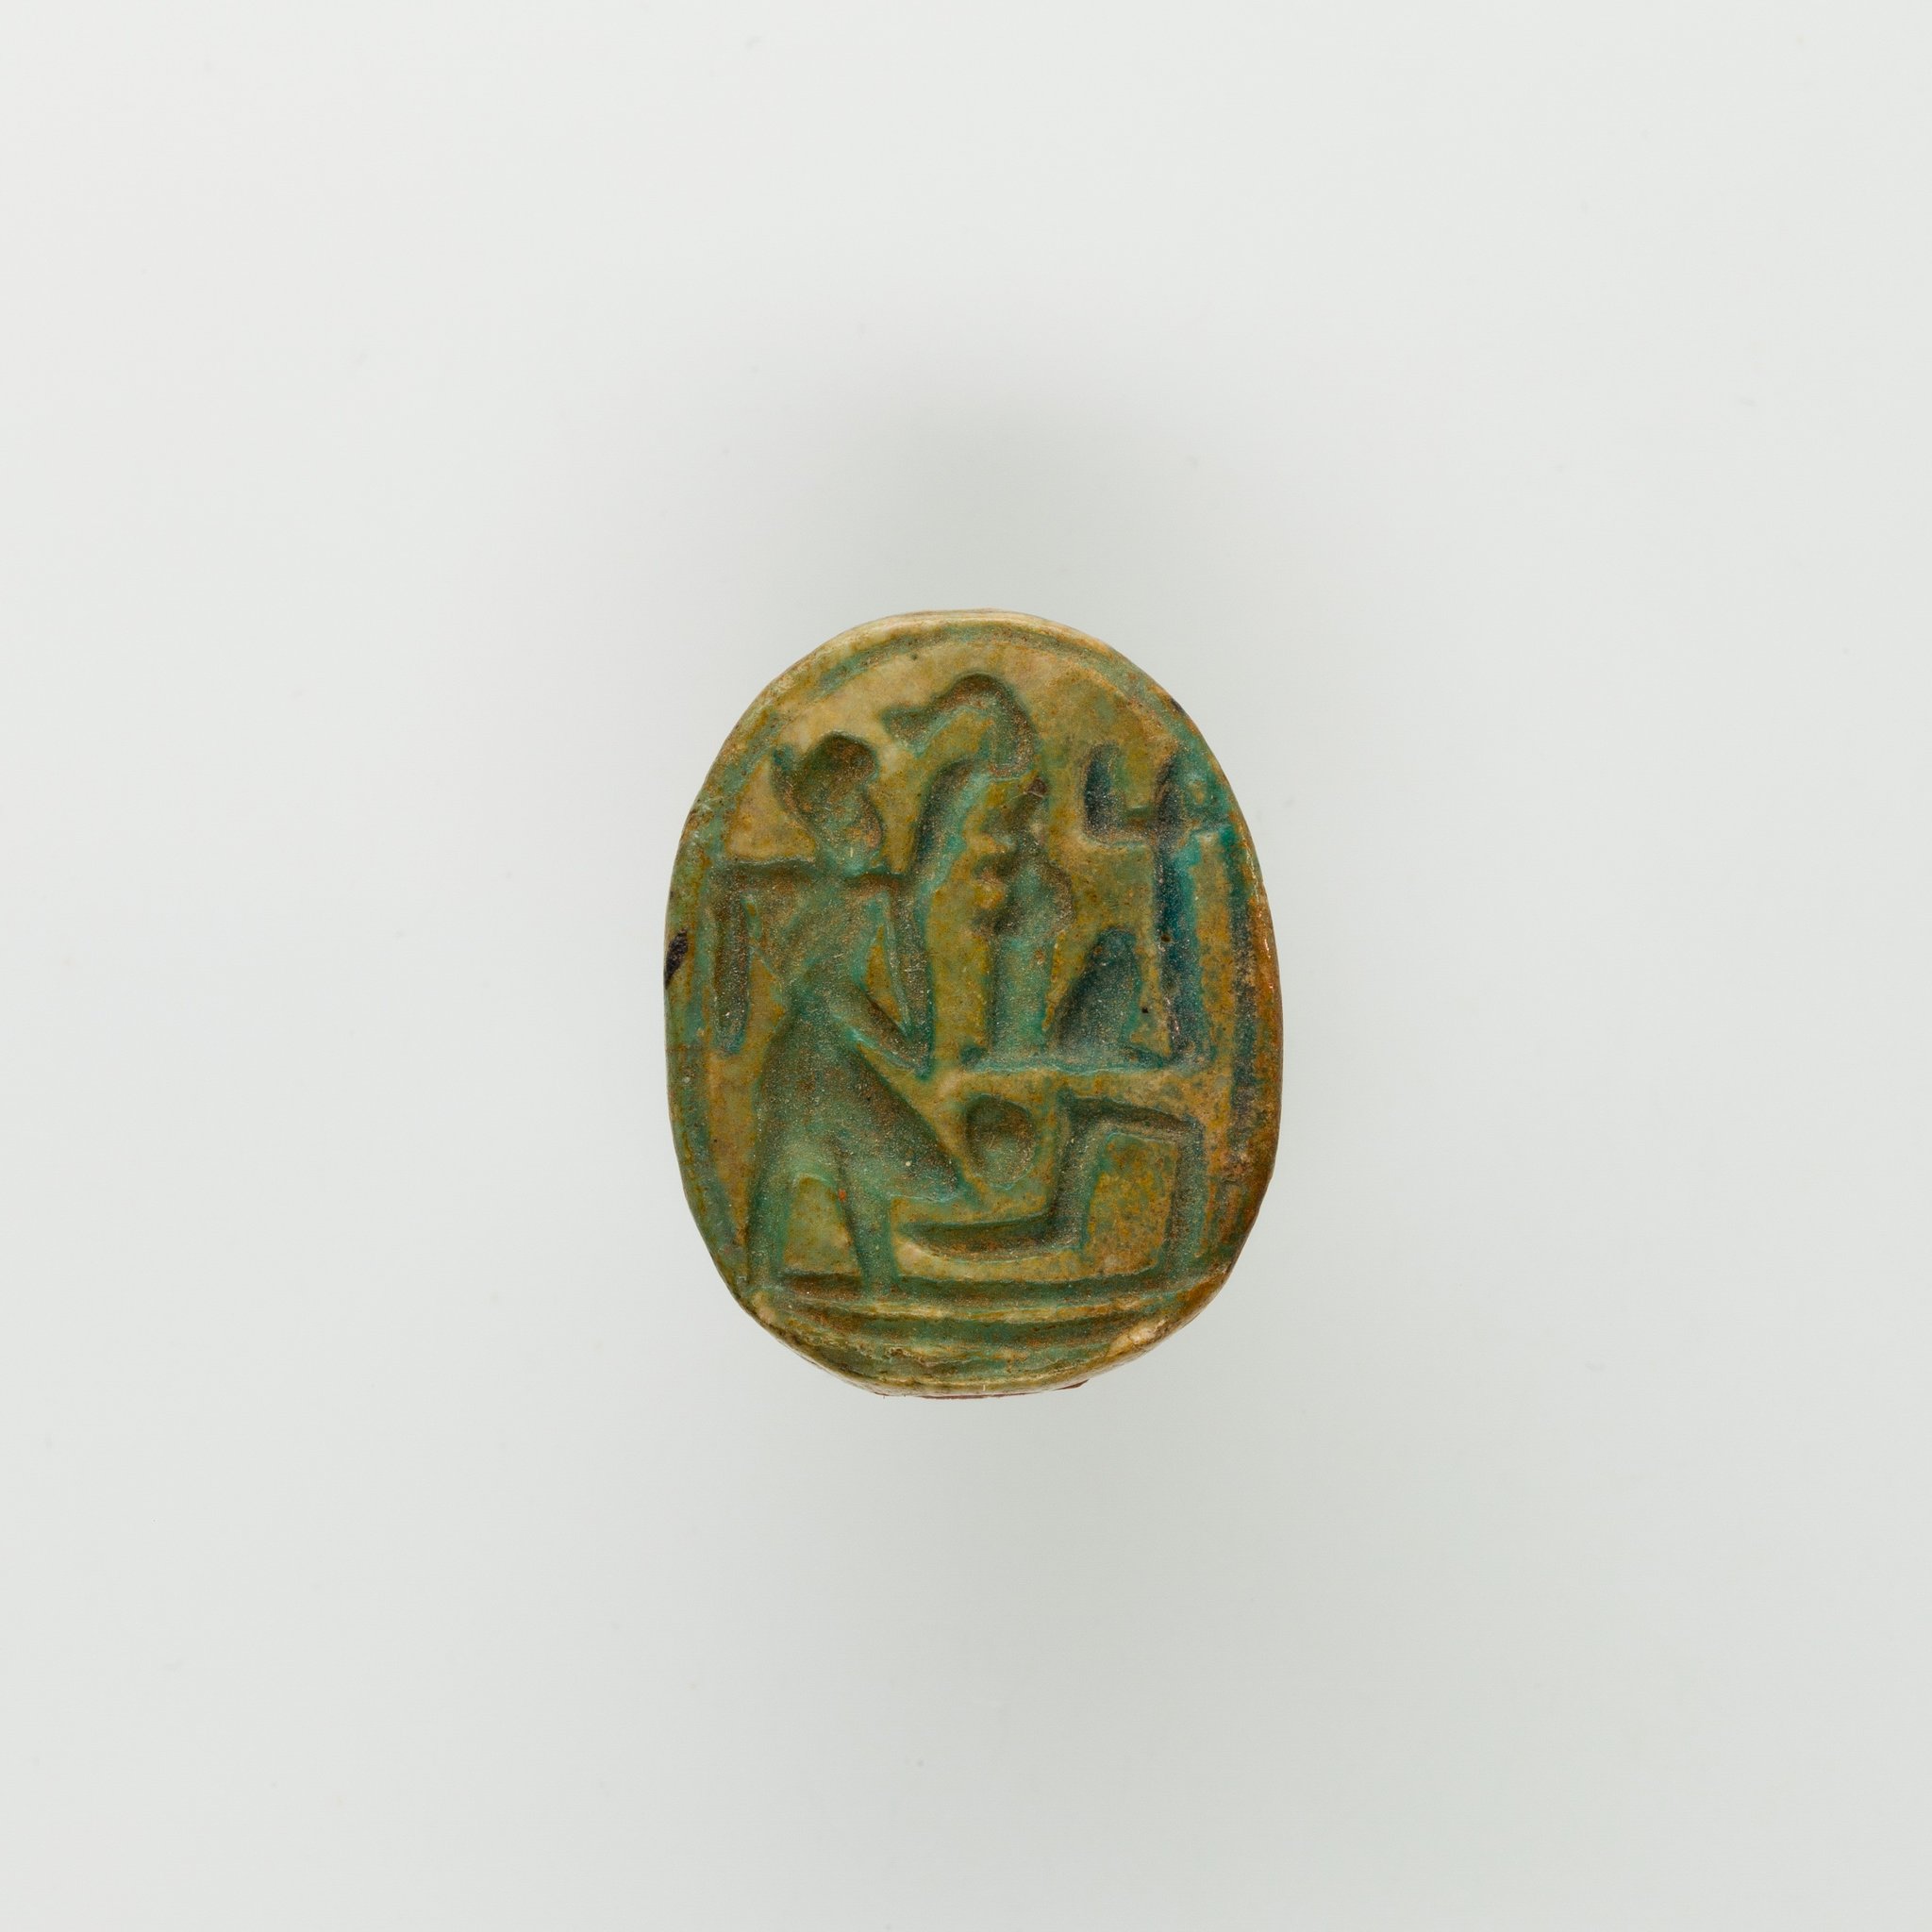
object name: scarab, ramesses ii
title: Scarab of Ramesses II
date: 1295-1070 BCE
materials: stone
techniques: glazing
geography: egypt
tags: scarabs